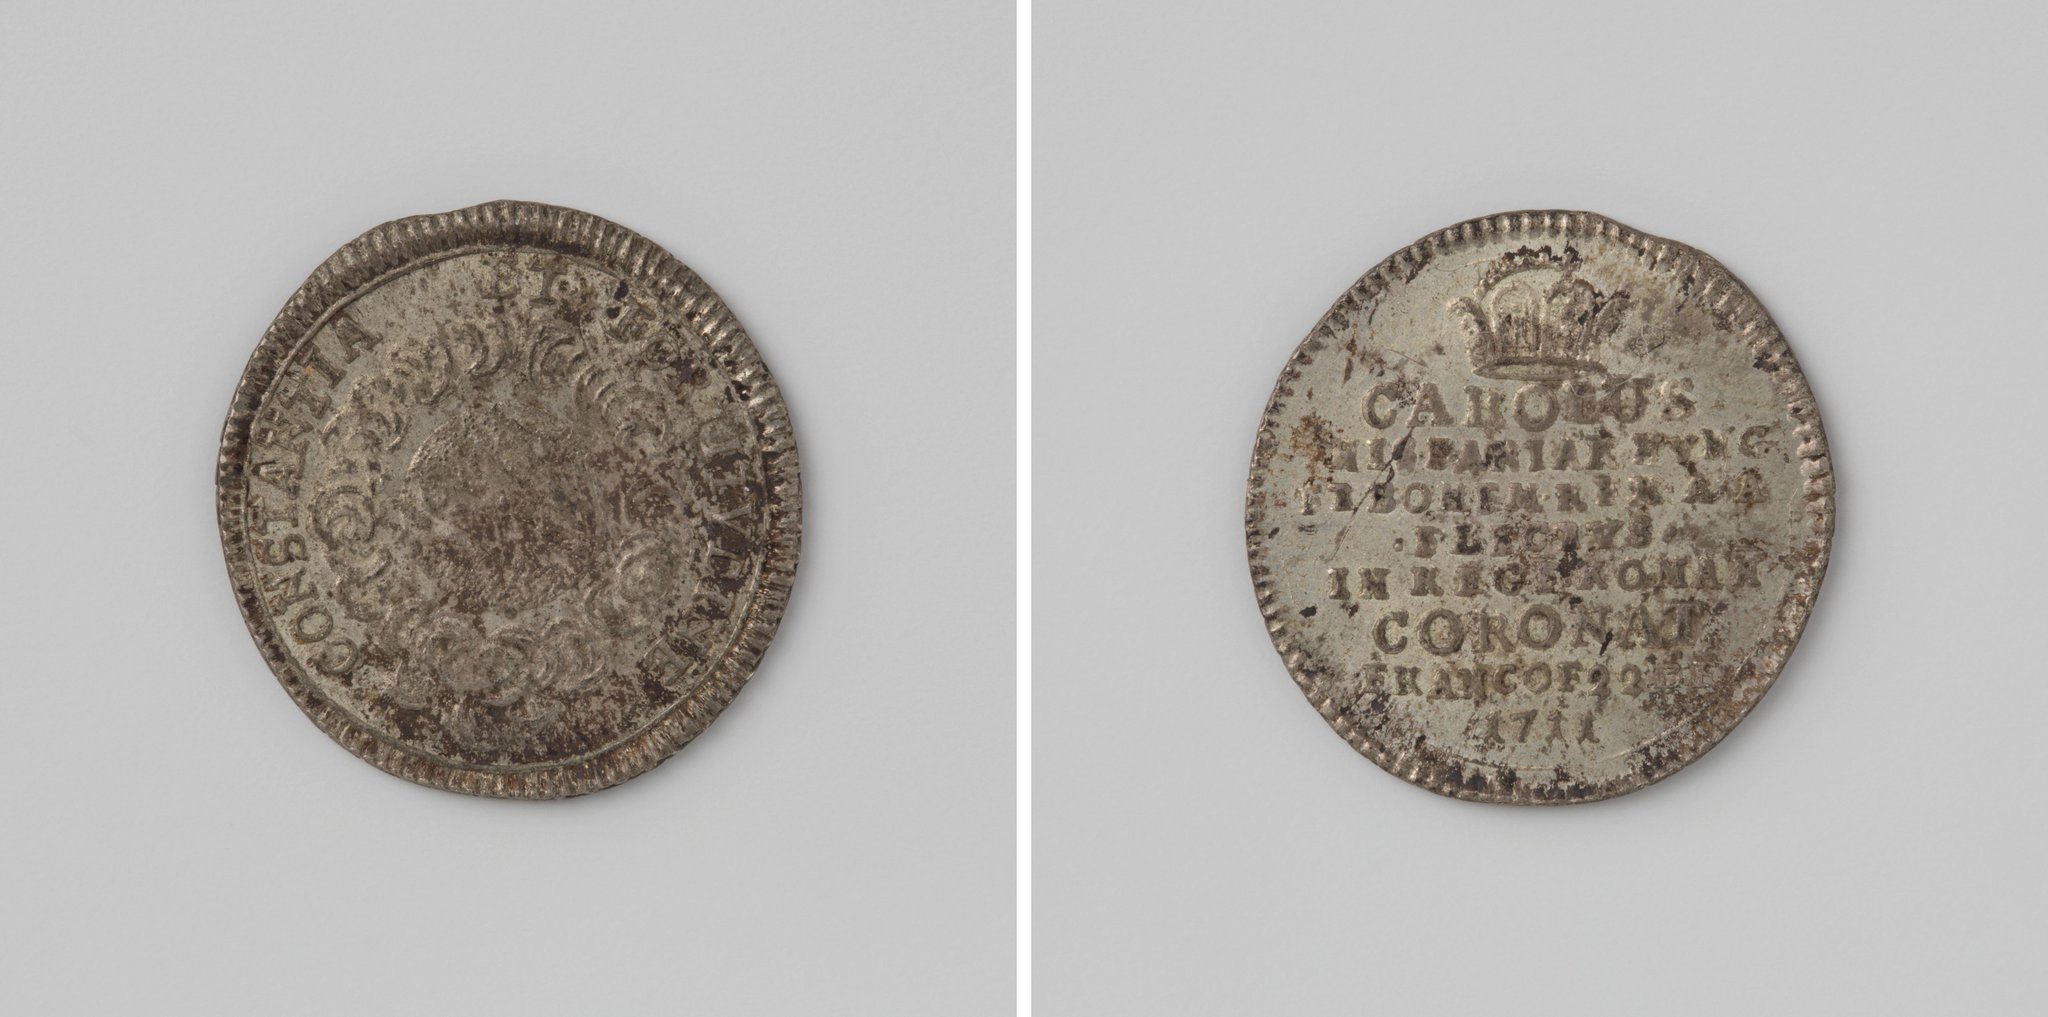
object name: strooipenning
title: Karel VI gekozen tot Duits keizer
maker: Anonymous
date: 1711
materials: silver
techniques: striking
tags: charles vi (holy roman emperor)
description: Zilveren penning. Voorzijde: wereldbol binnen ring van wolken en omschrift. Keerzijde: opschrift onder kroon